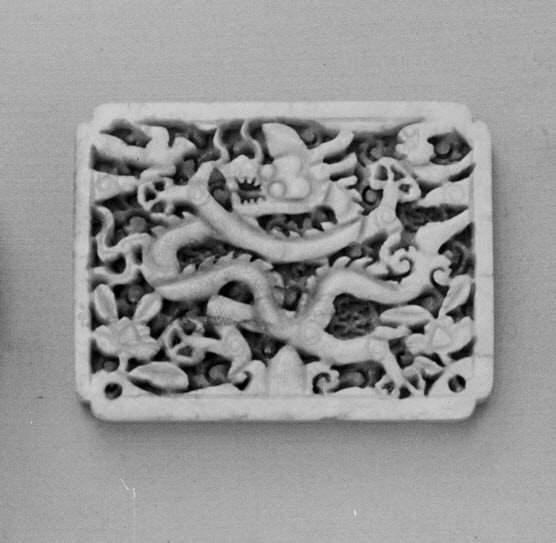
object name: belt plaque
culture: chinese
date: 1368-1644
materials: jade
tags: dragons